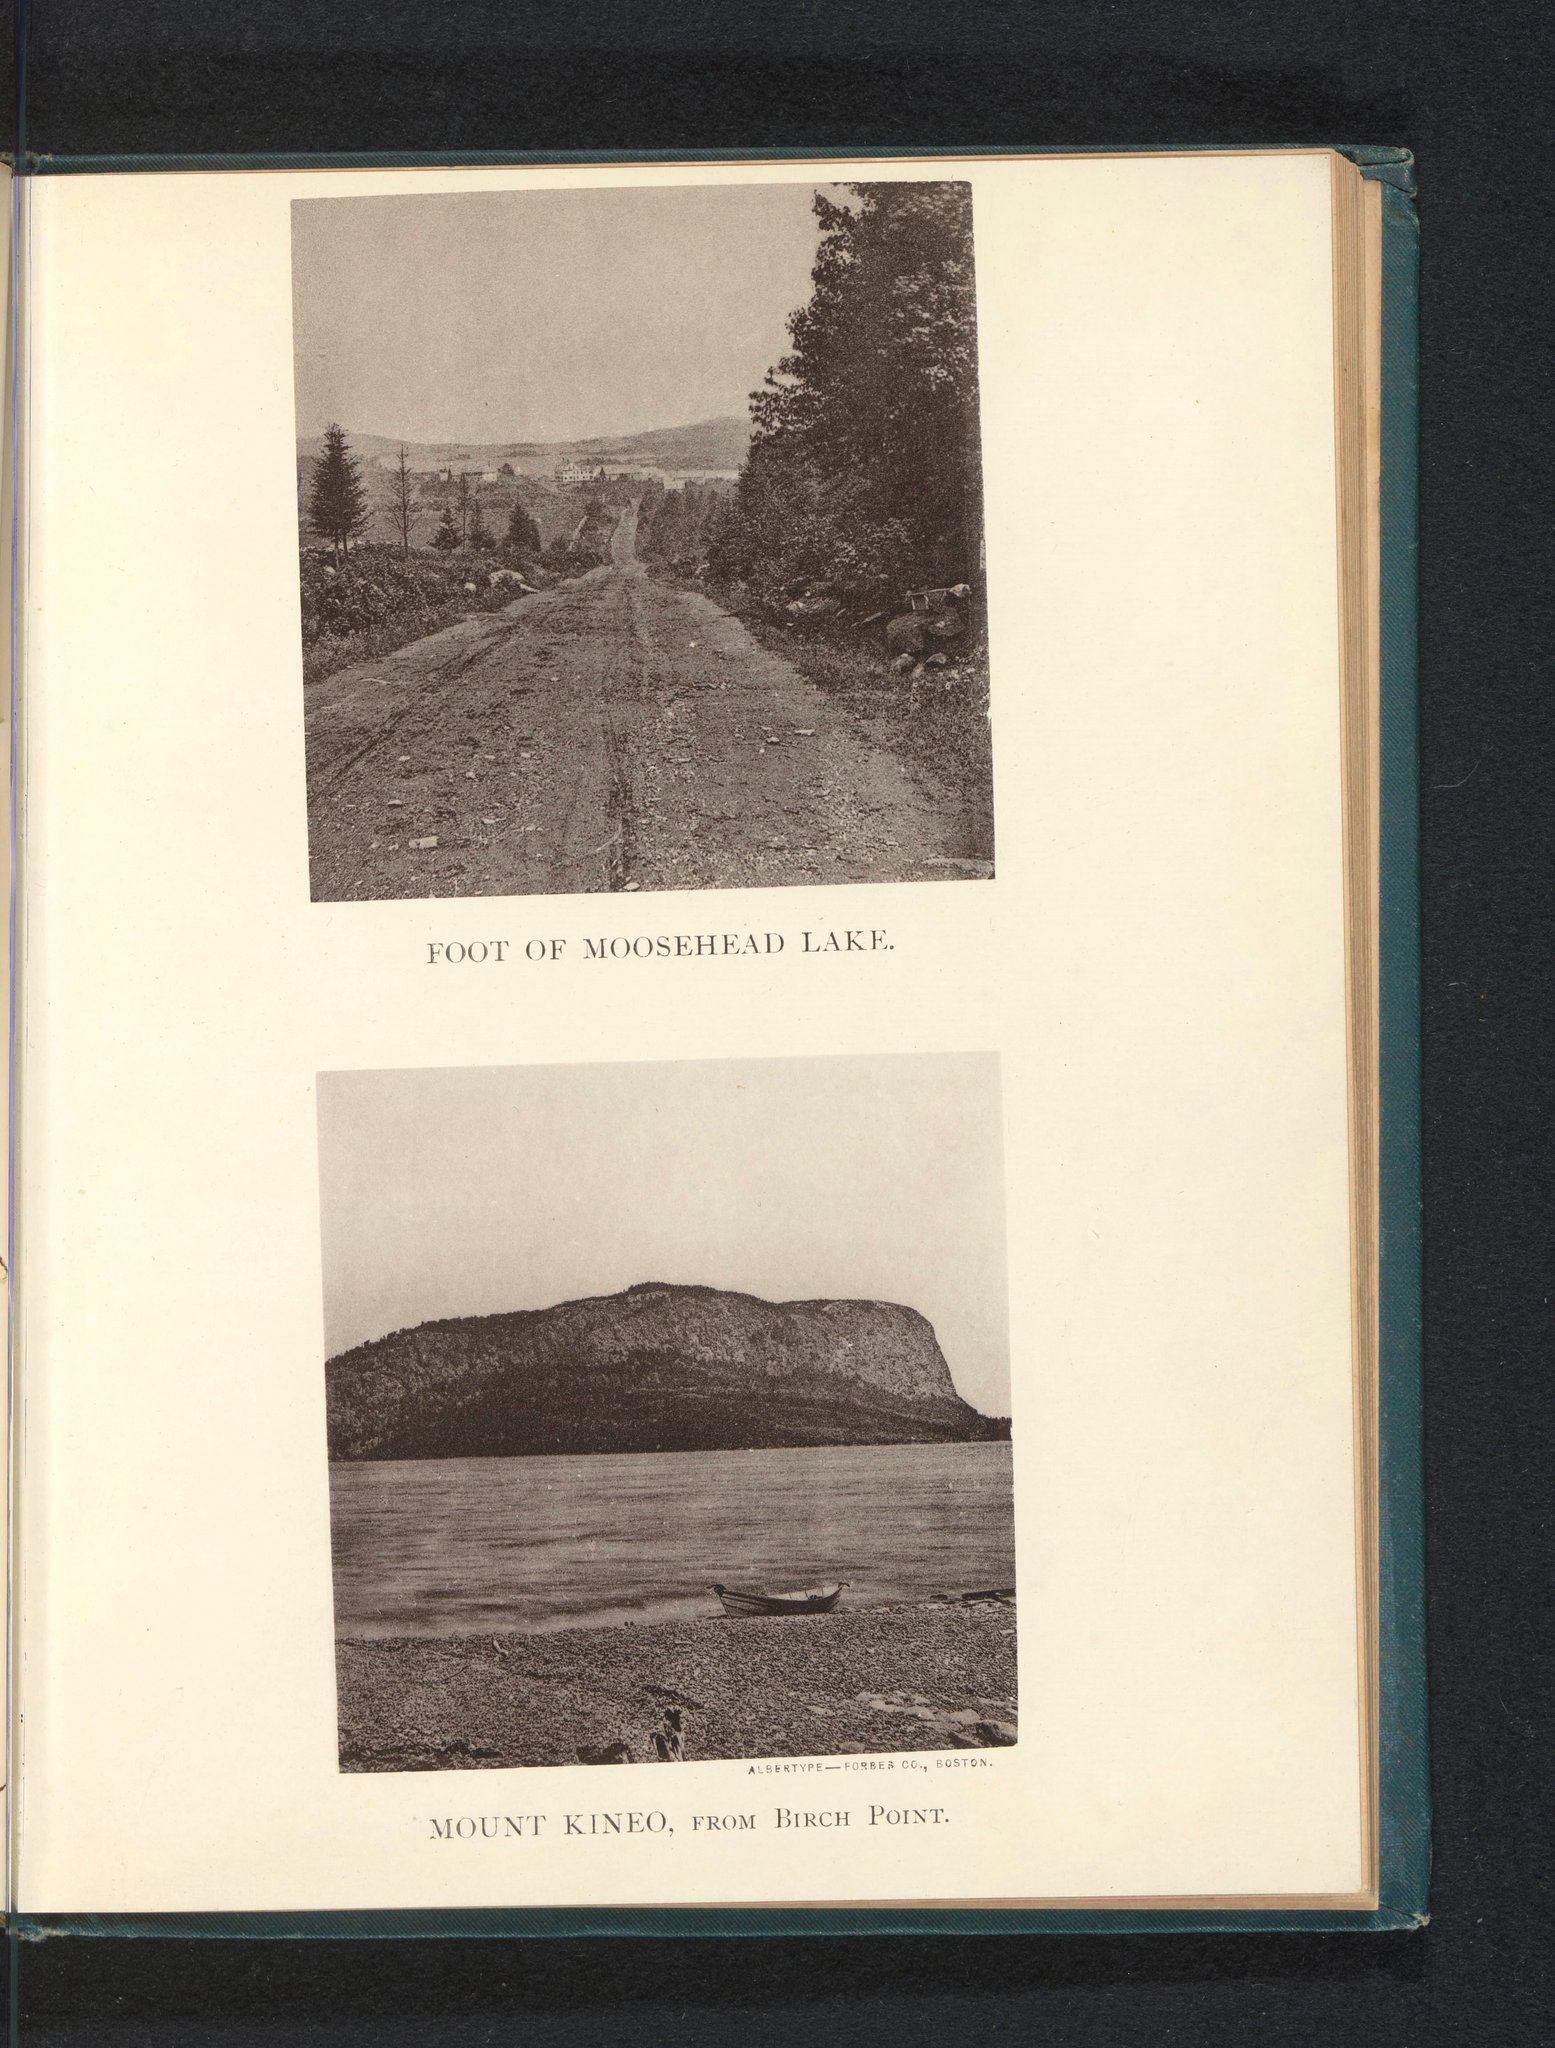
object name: page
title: Gezicht op een landweg met op de achtergrond Moosehead Lake, Maine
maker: Anonymous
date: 1875-1880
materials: paper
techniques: photograph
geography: moosehead lake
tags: lake, road, path